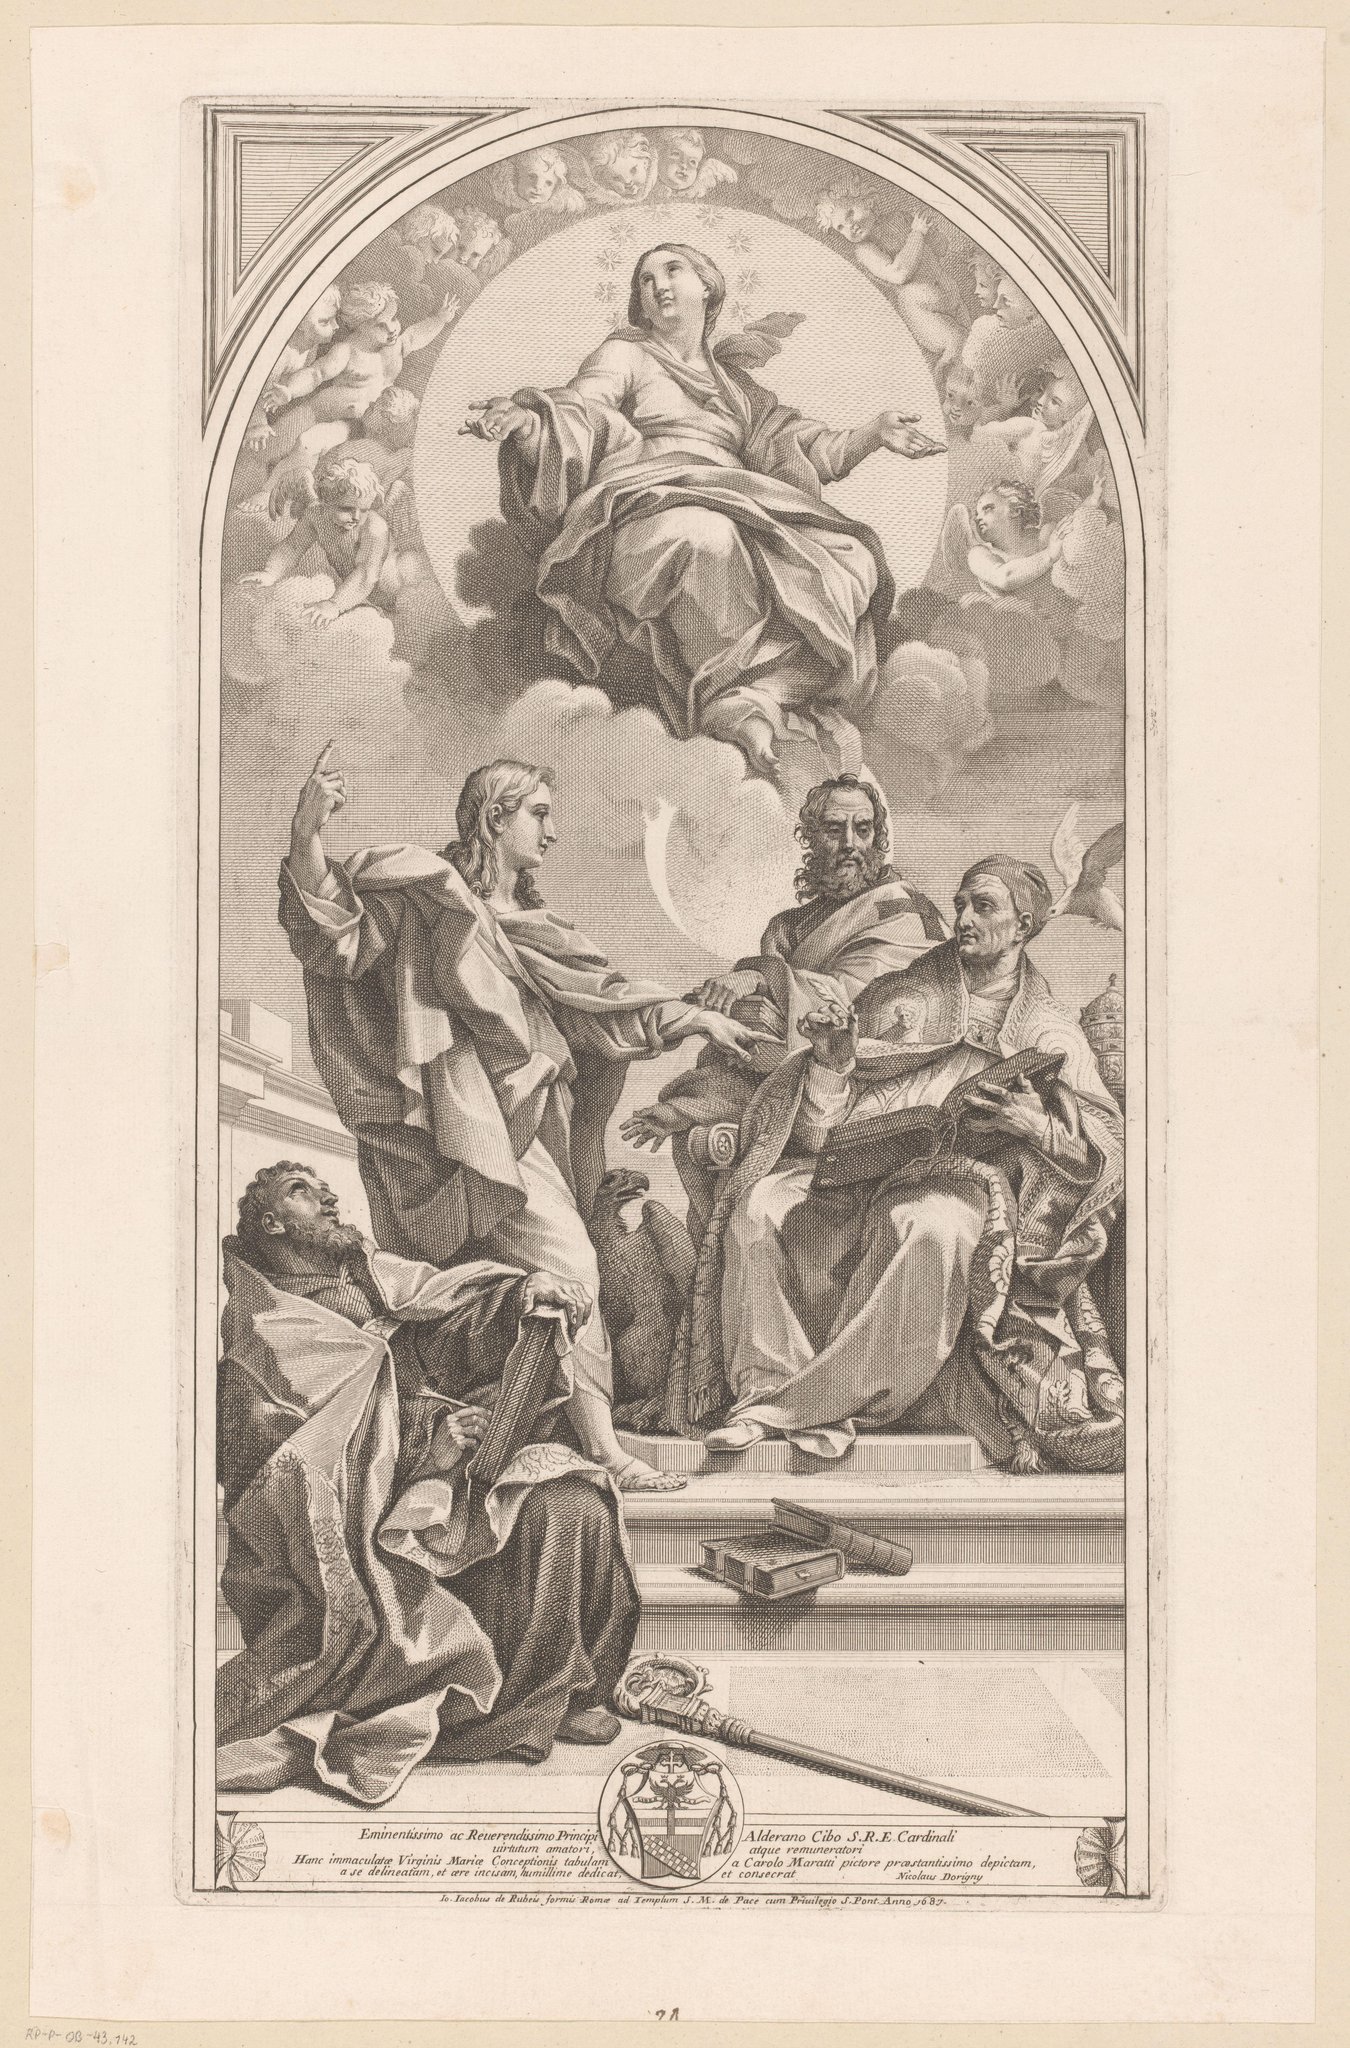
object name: print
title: Johannes de Doper legt de doctrine van de Onbevlekte Ontvangenis uit aan H. Gregorius, H. Augustinus en Johannes Chrysostomos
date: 1687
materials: paper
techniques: engraving, etching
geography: france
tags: augustine, bishop of hippo; possible attributes: arrows piercing his breast, book, child with spoon, flaming heart, heart (pierced with arrows), pen, madonna (i.e. mary with the christ-child) in the air, or on the clouds, series of scenes from the life of john the baptist, the archbishop of constantinople, john chrysostom; possible attributes: beehive, dove, pope gregory the great; possible attributes: dove, emperor trajan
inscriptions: collector's mark: Lugt 240